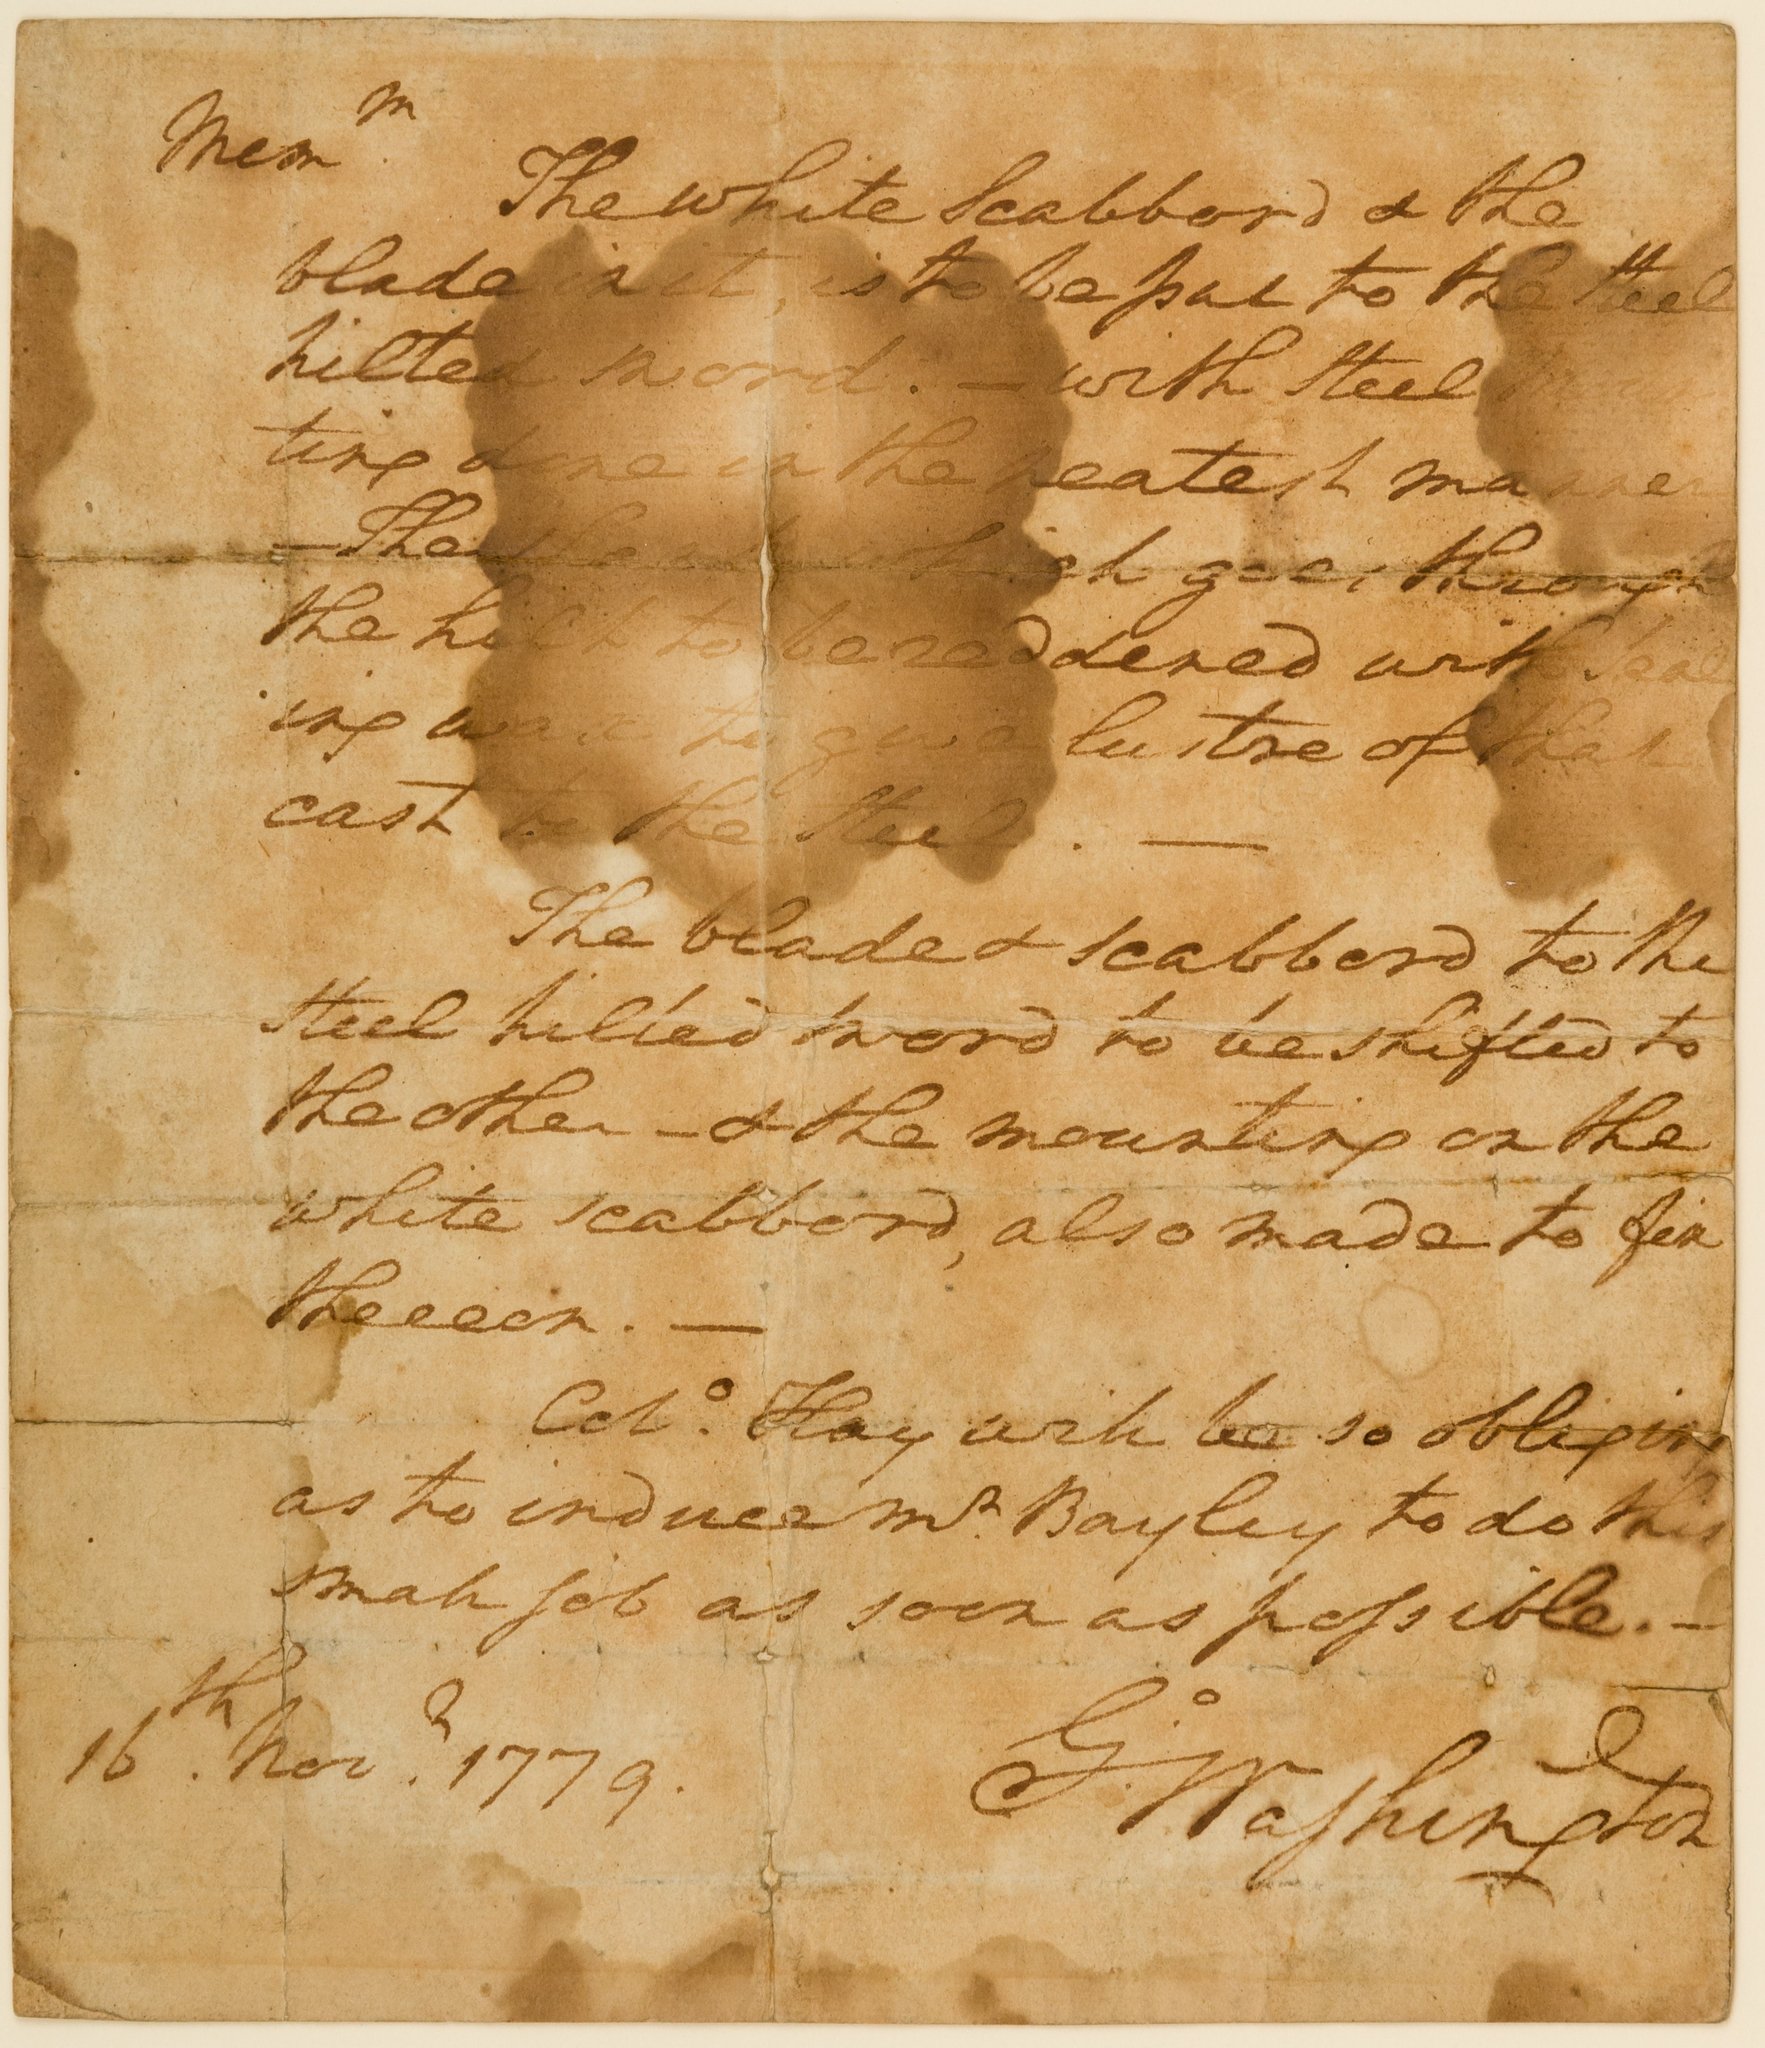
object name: memorandum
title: Manuscript Memorandum of George Washington Describing Work to be Done on His Swords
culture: american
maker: george washington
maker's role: author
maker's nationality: american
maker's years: 1732-1799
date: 1779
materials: ink, paper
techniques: pen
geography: united states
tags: manuscripts,george washington